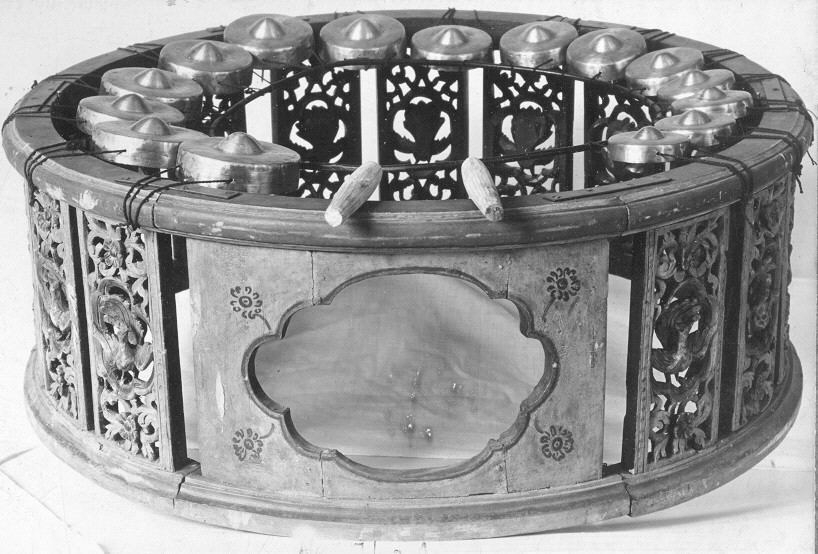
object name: kyì waìng gong chime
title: Kyì-waìng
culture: burmese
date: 1867-1900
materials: metal, wood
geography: myanmar